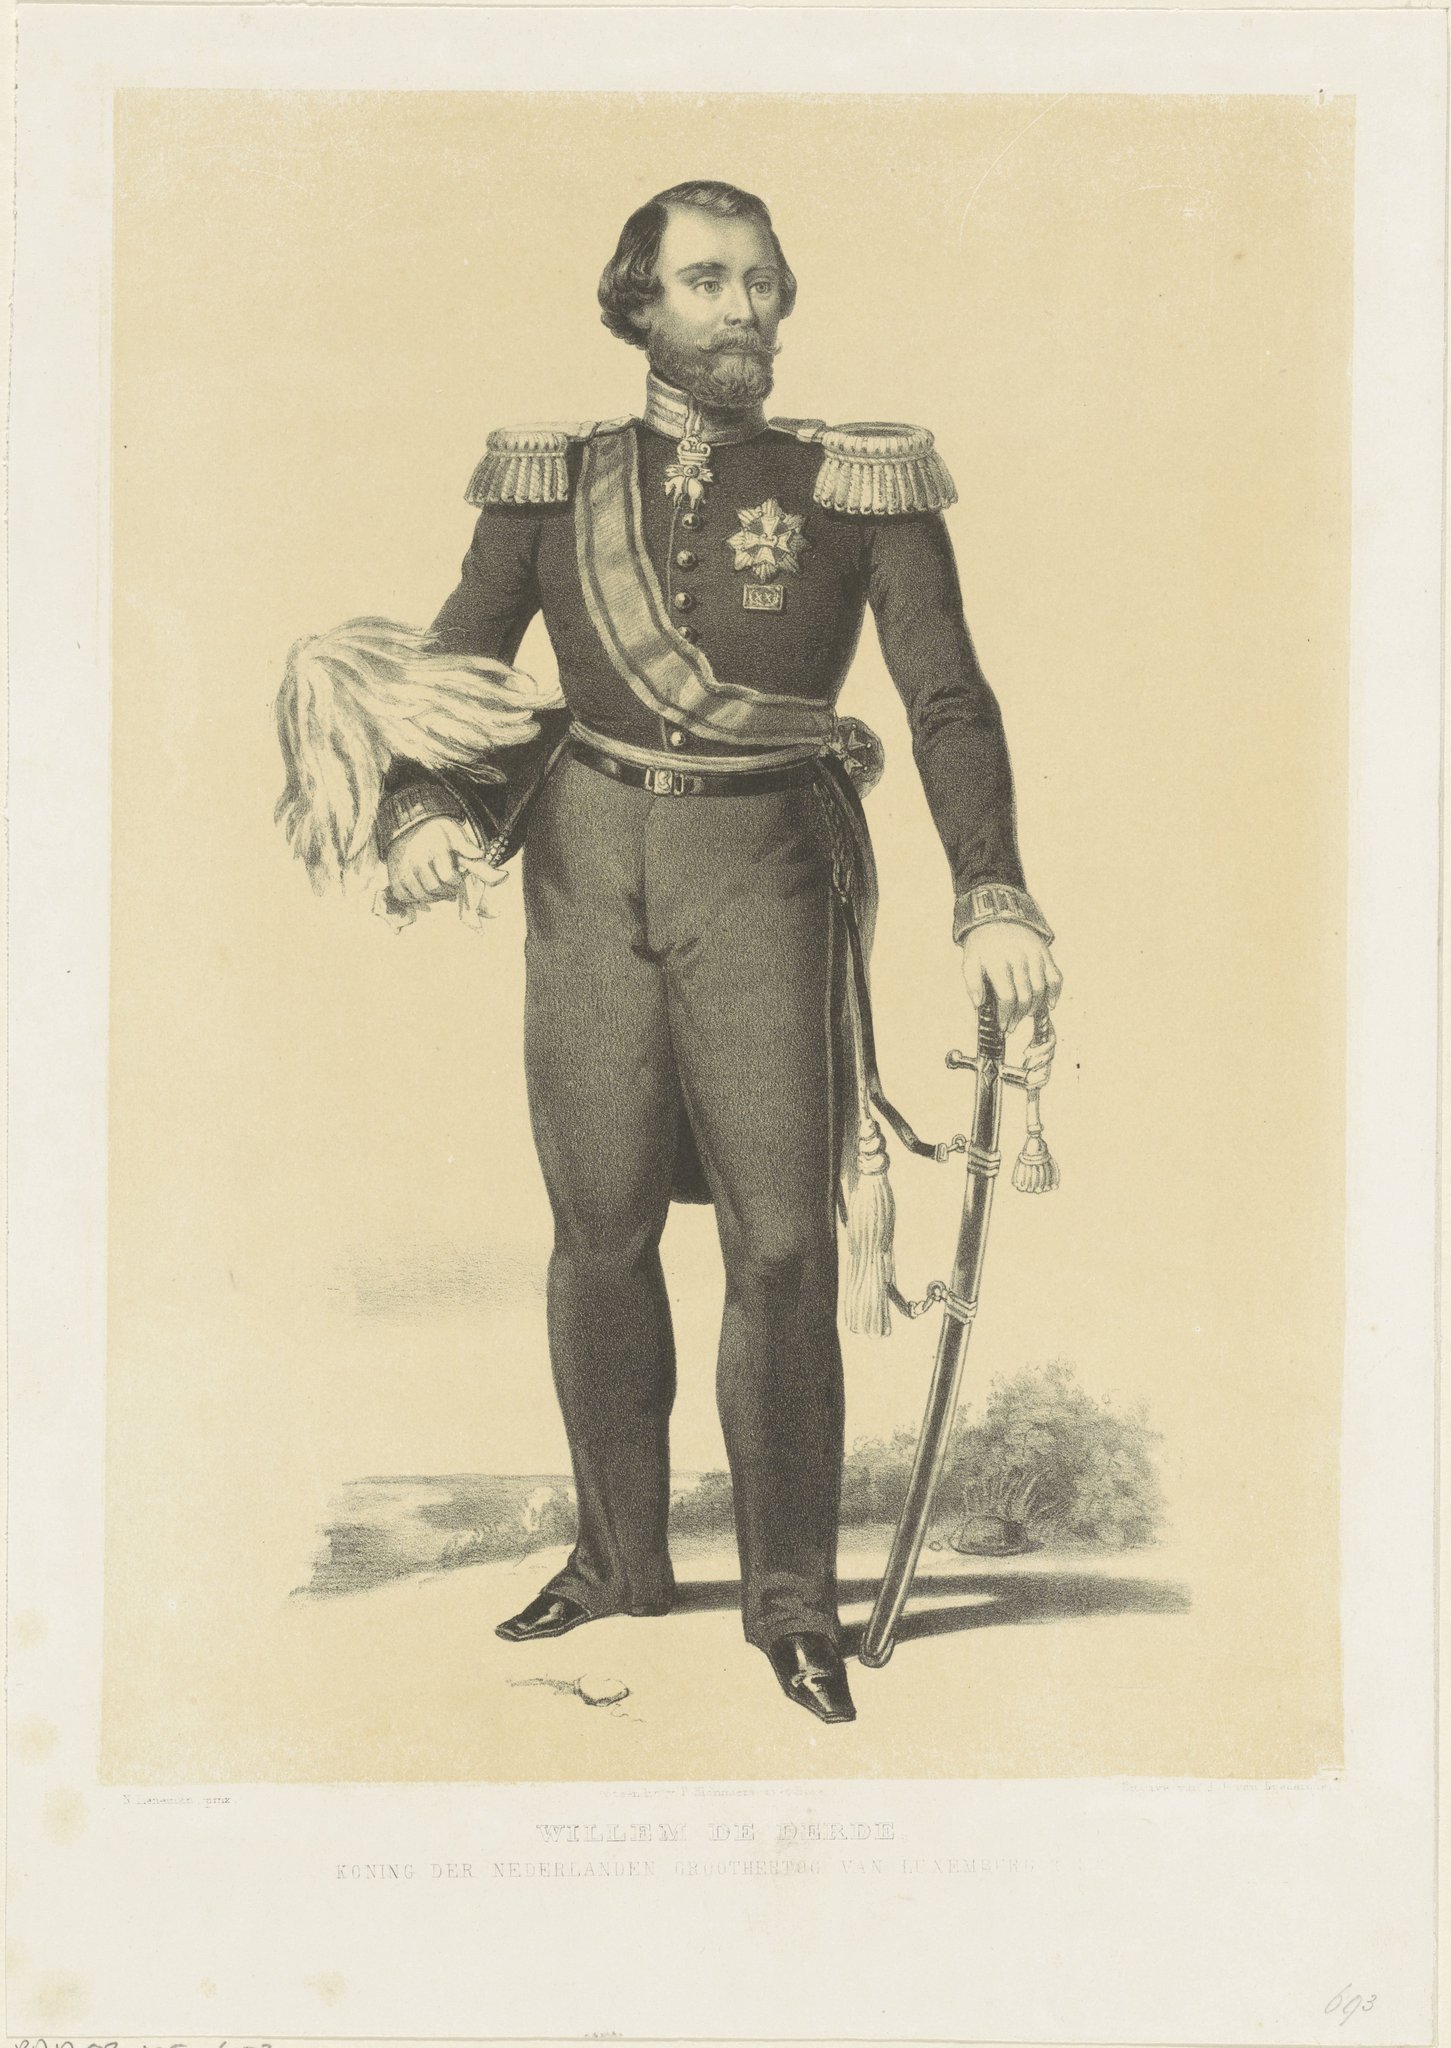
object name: print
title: Portret van Willem III, koning der Nederlanden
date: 1847-1883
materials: paper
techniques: tone lithography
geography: netherlands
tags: brussels, willem iii (koning der nederlanden), knighthood order of the golden fleece - insignia of a knighthood order, e.g.: badge, chain (with name of order)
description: De hier vermelde titel verwijst naar de hoogst verkregen titel van de geportretteerde, niet per se naar de titel die de geportretteerde op deze voorstelling draagt.